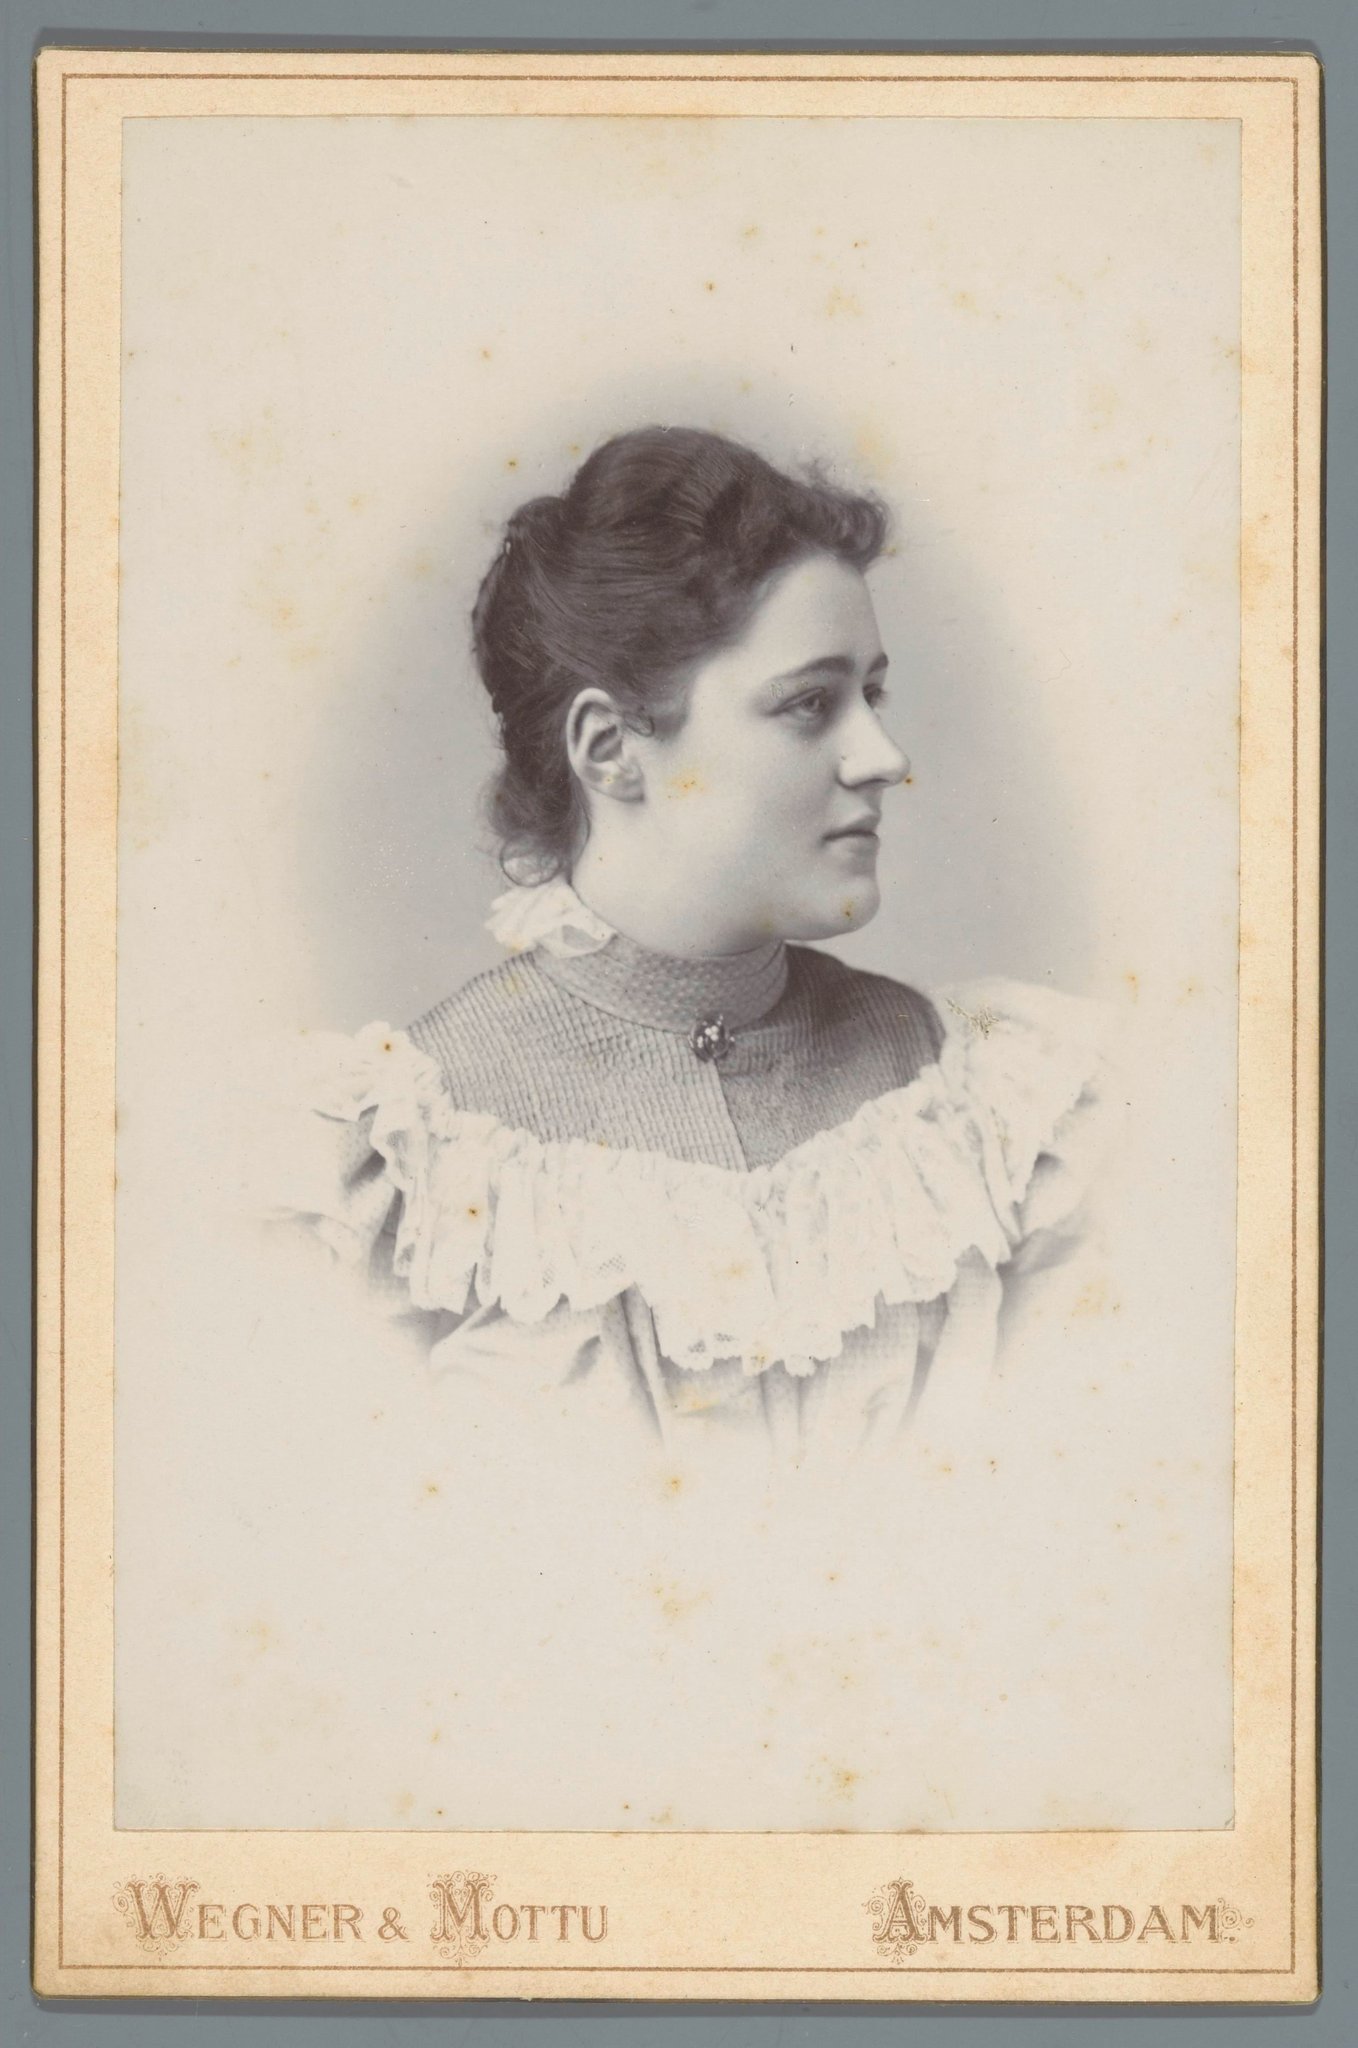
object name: cabinet photograph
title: Portret van een onbekende vrouw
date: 1880-1905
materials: cardboard, photographic support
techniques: daylight paper print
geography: amsterdam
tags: adult woman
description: Geportretteerde is ook afgebeeld op RP-F-F19081.